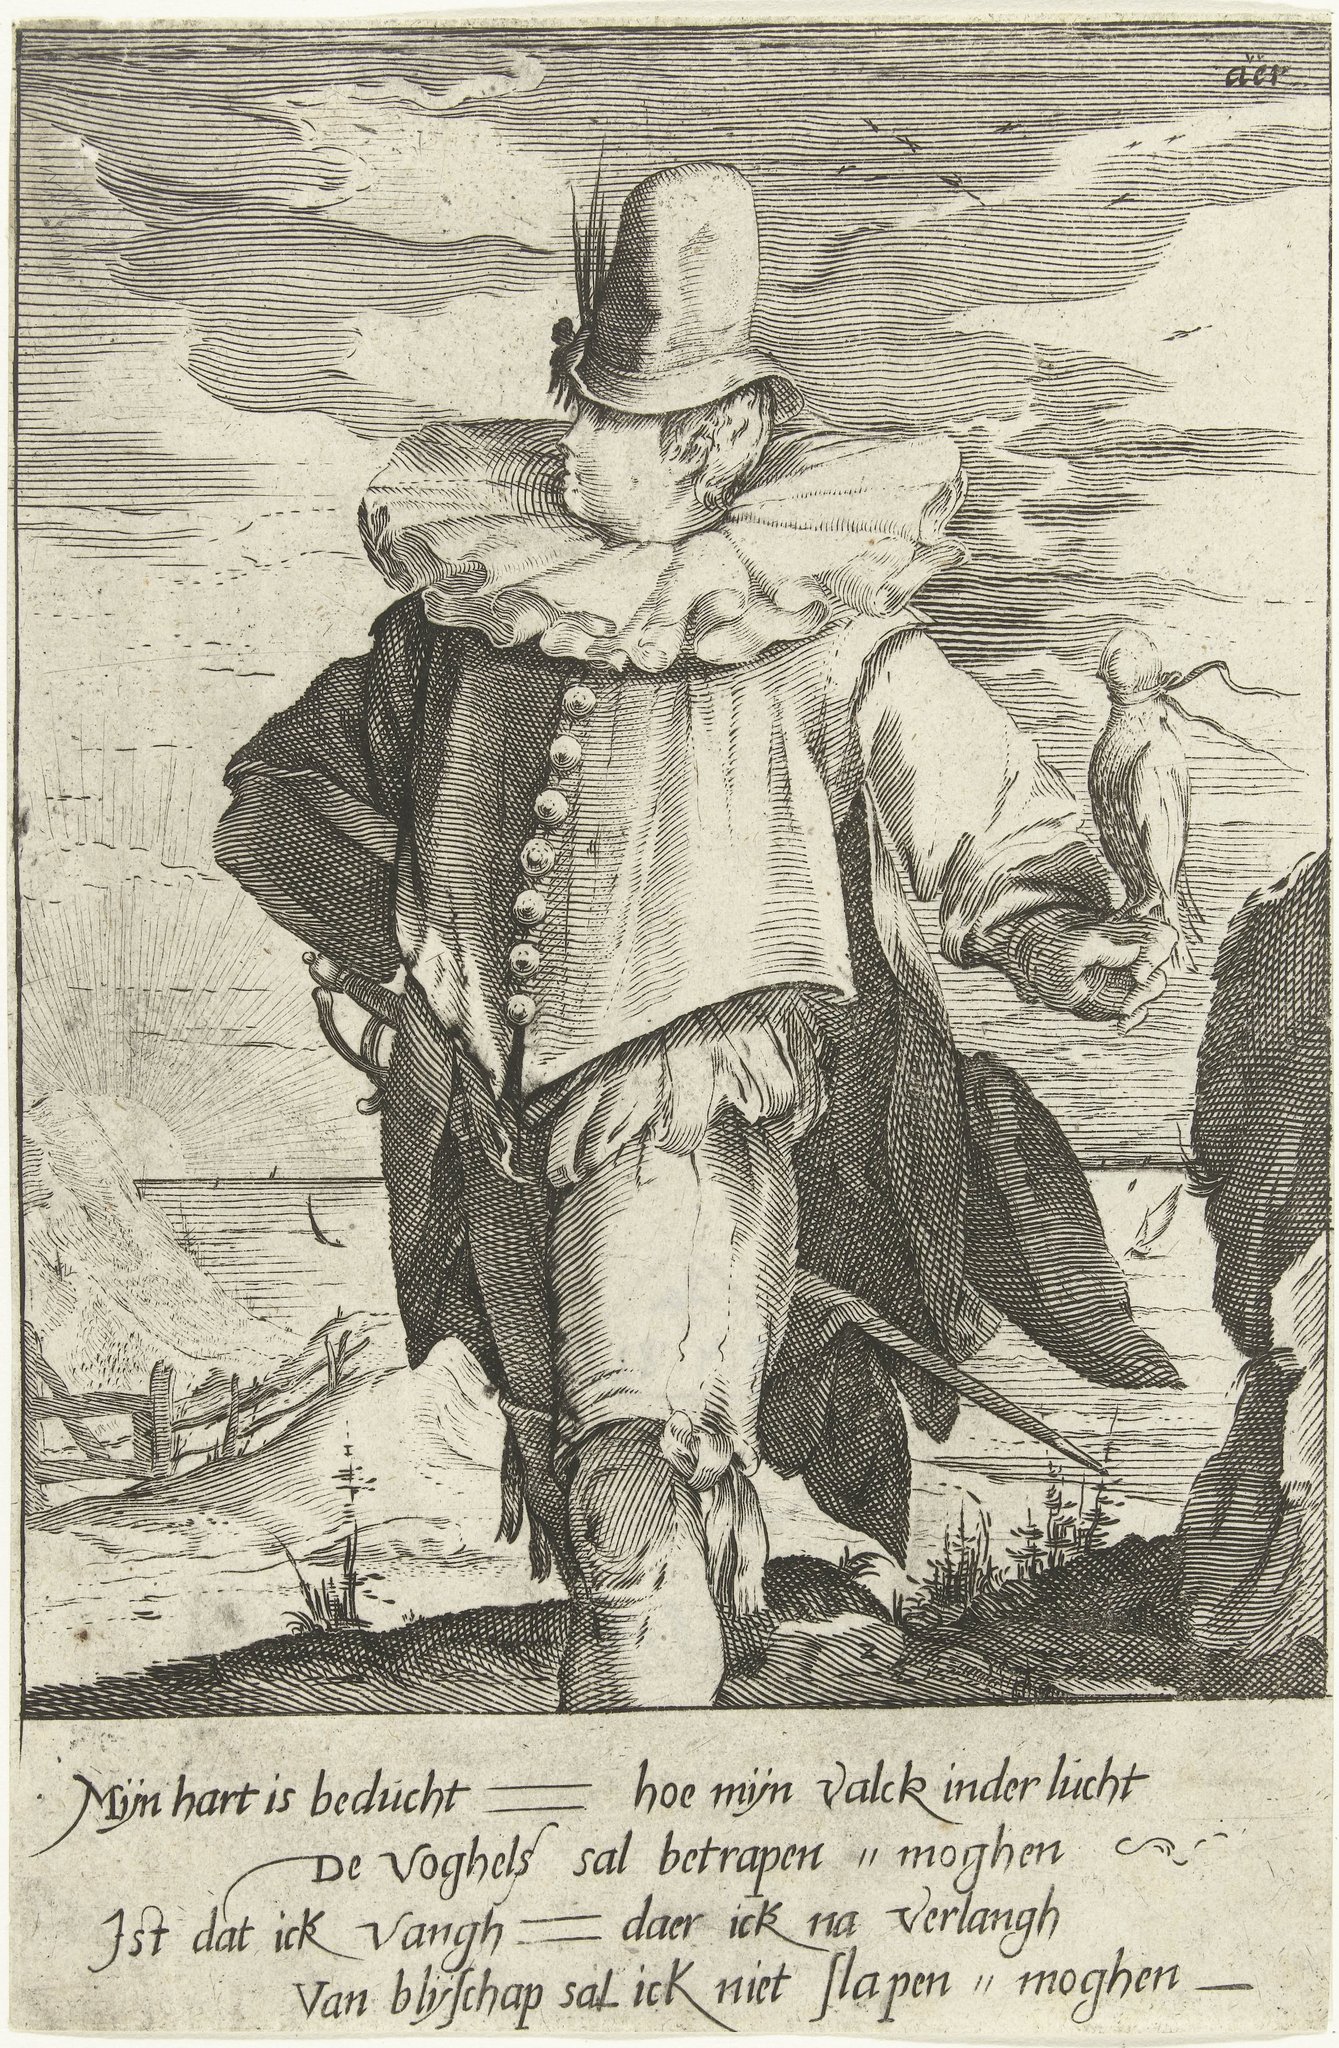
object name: print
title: Lucht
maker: nicolaes jansz. clock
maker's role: print maker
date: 1597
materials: paper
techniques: engraving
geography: haarlem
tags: predatory birds: falcon, air (one of the four elements), sports, games ~ animals (+ hunting with falcon, hawk; falconry)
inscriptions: collector's mark: Lugt 2228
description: Een valkenier met een jachtvalk op zijn linkerhand. De man symboliseert het element lucht. Hij heeft een statige houding en is hoffelijk gekleed. De prent heeft een Nederlands onderschrift dat de valkenier omschrijft. De prent is deel van een vierdelige serie over de vier elementen.